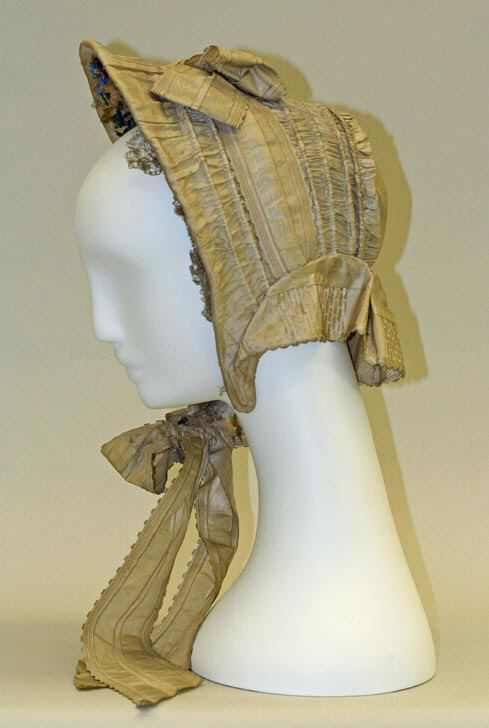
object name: bonnet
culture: american or european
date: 1863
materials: silk